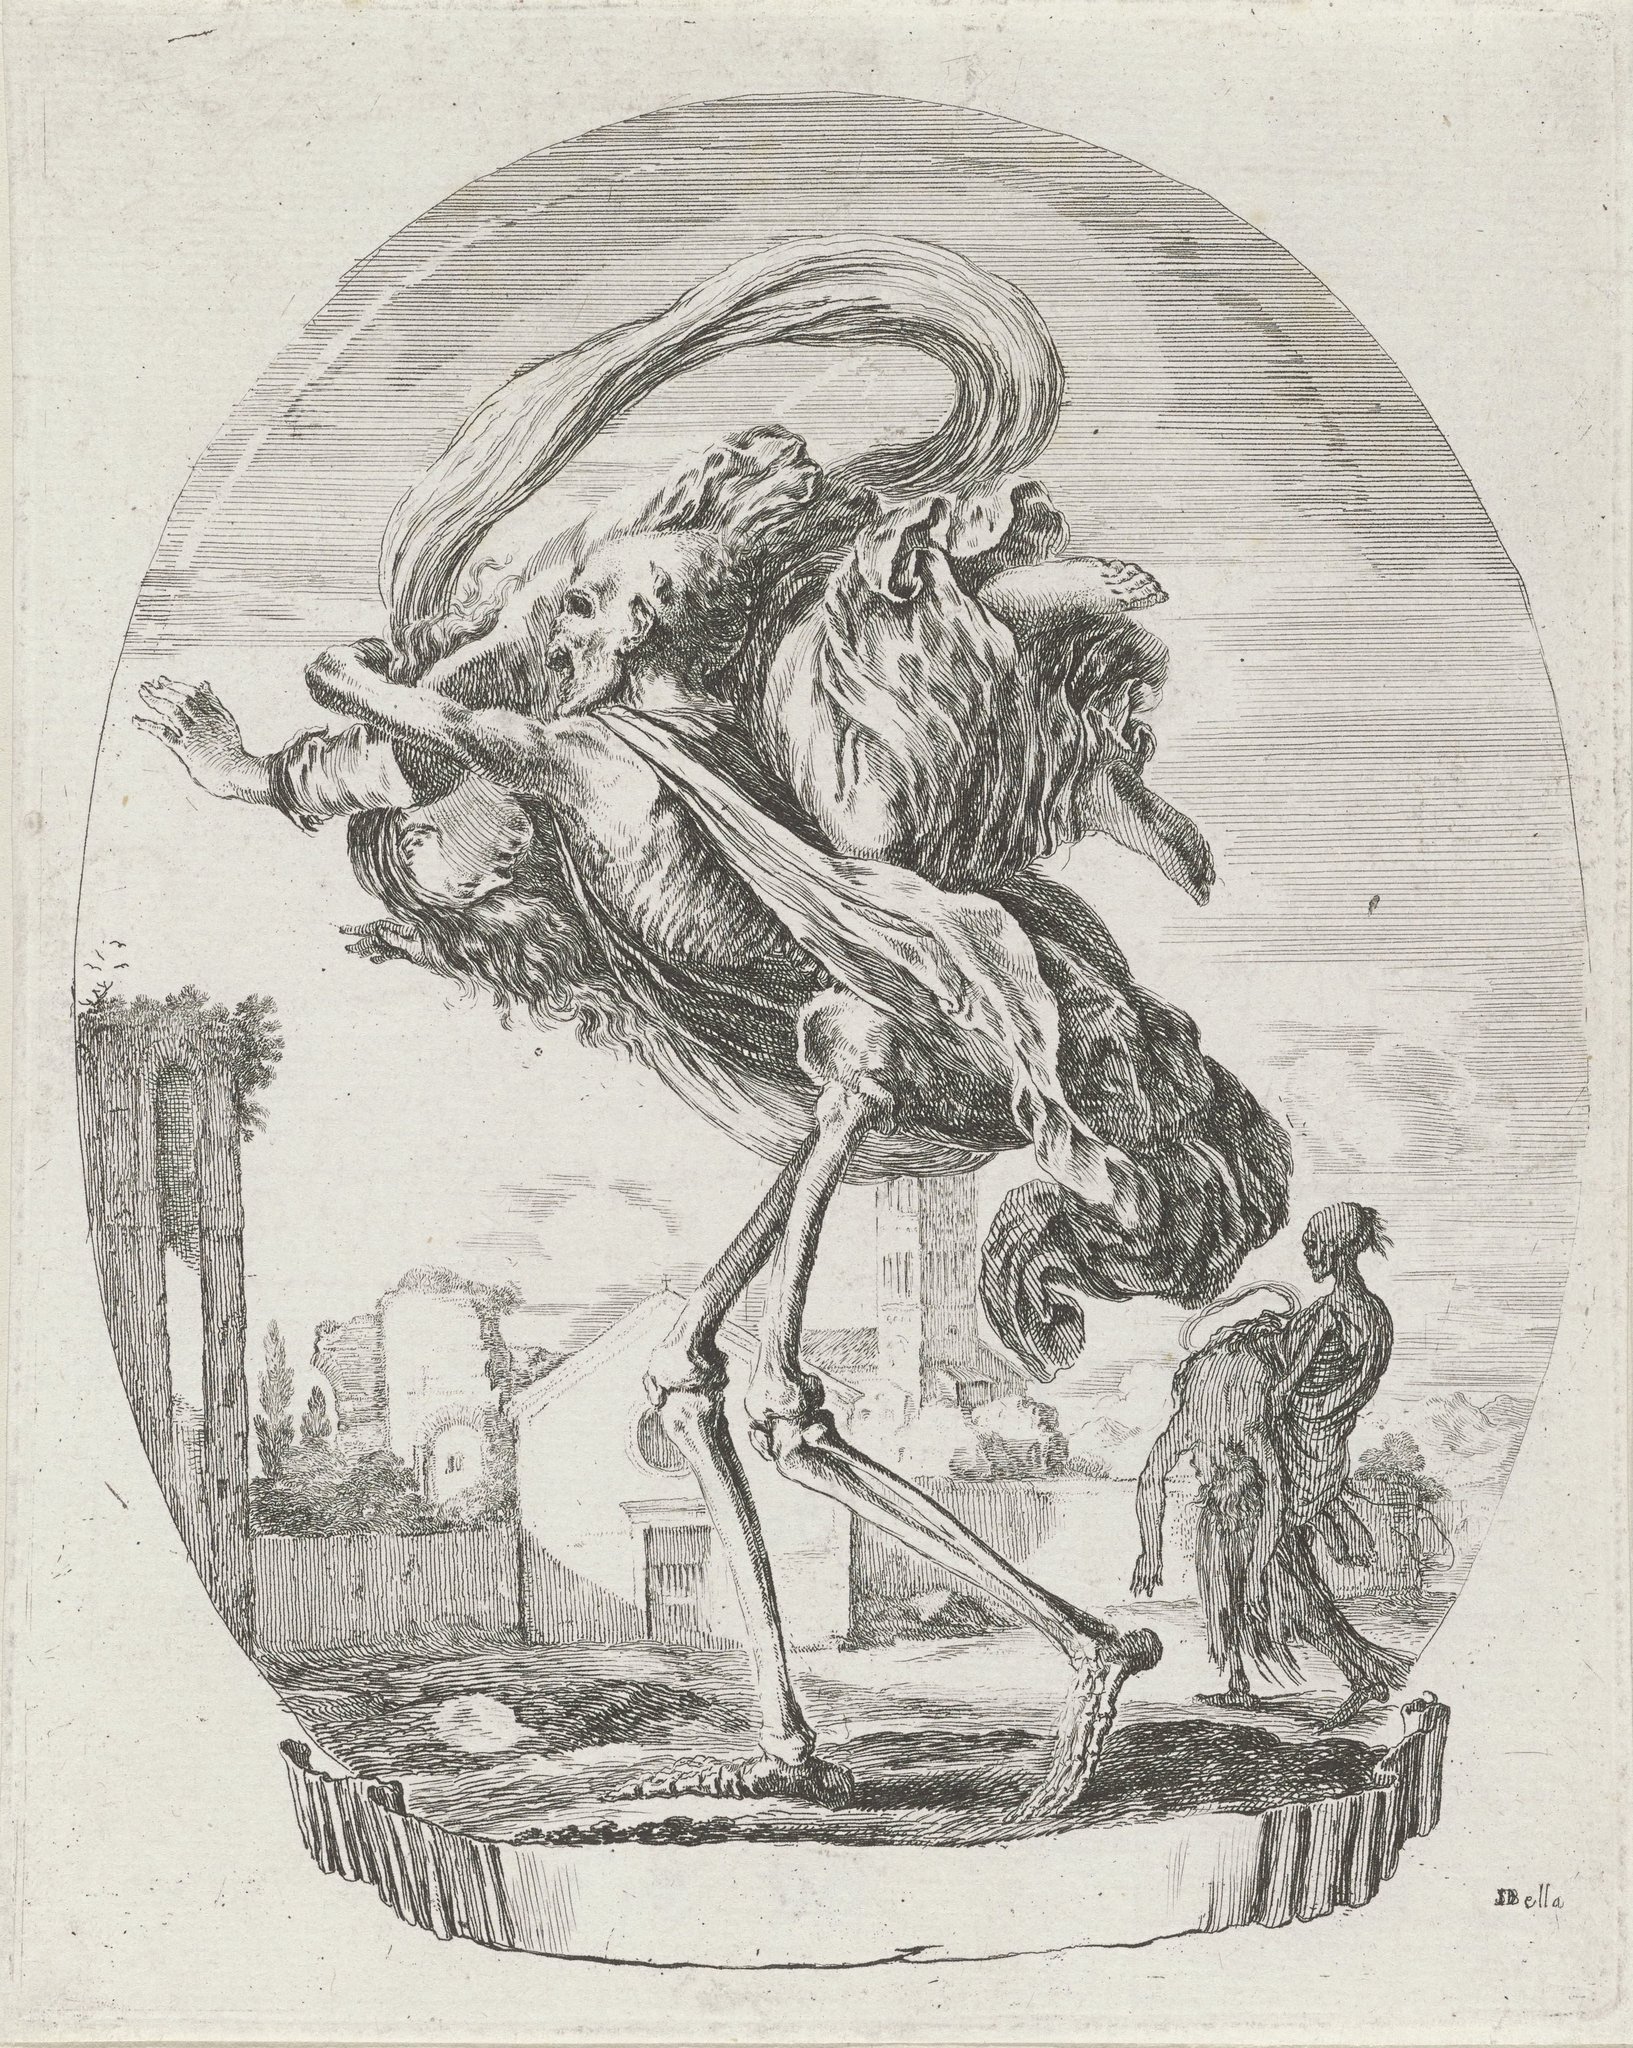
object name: print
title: De Dood met een vrouw over zijn schouder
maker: stefano della bella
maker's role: draughtsman, print maker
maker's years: 1610-1664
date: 1620-1664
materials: paper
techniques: etching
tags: meeting between the (three) living and the (three) dead, death as skeleton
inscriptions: collector's mark: Lugt 240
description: De Dood als een skelet met een vrouw over zijn schouder. Op de achtergrond een tweede skelet met een vrouw in zijn armen.